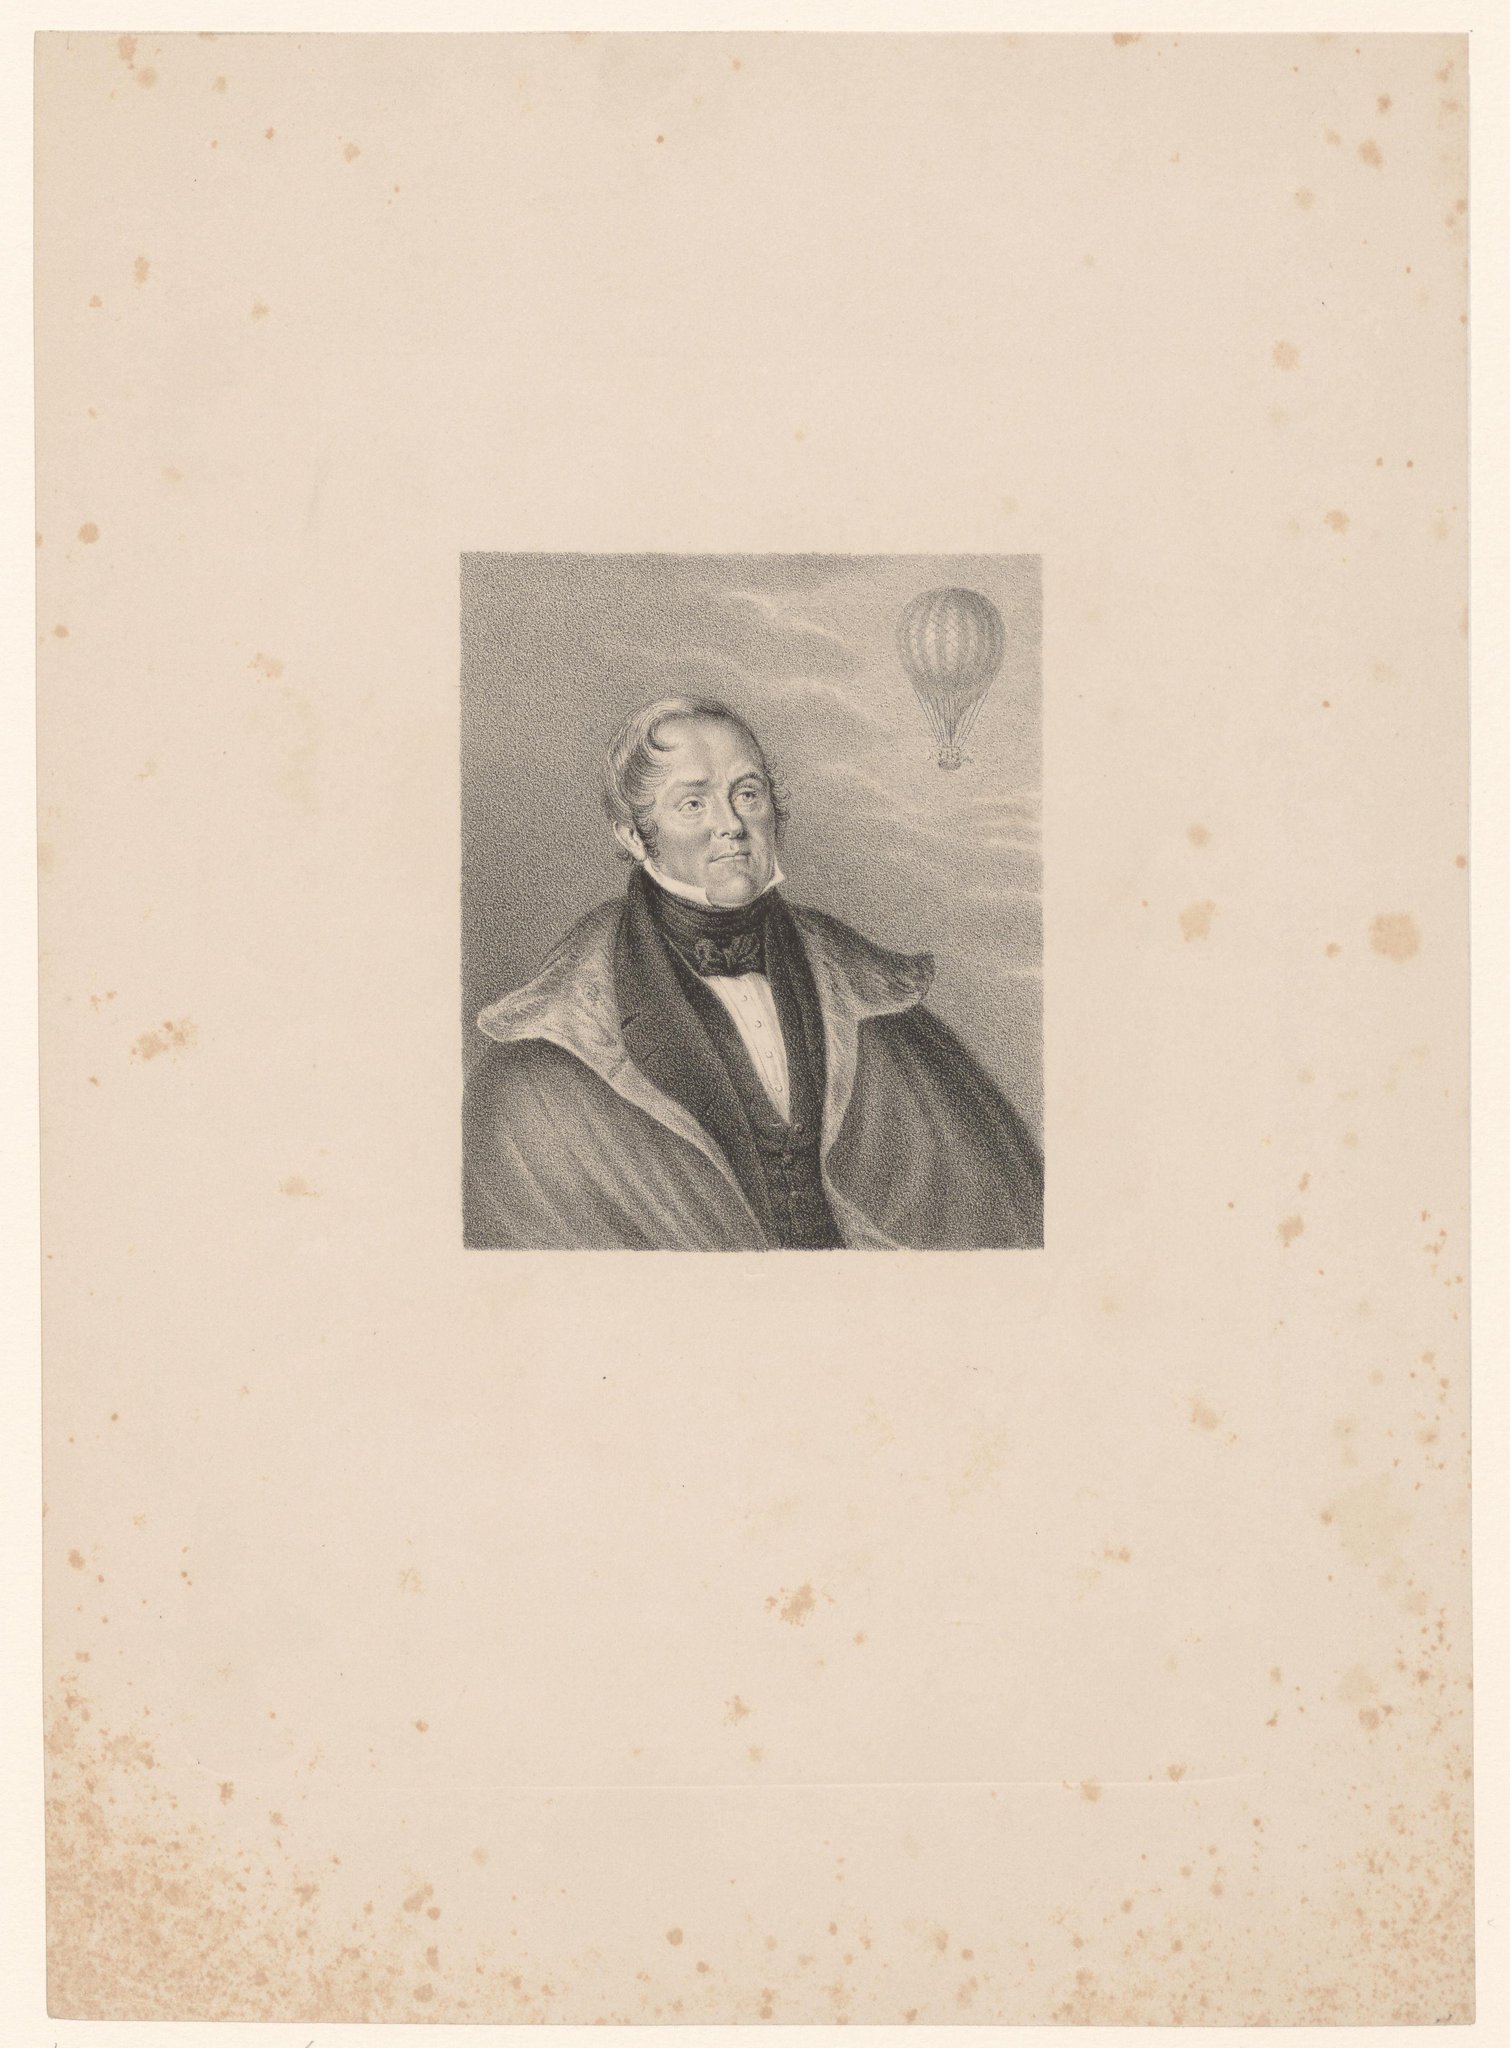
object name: print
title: Portret van Charles Green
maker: george perfect harding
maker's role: print maker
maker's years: 1780-1853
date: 1839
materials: paper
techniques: lithograph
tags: adult man, historical persons, balloon (aviation)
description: Charles Green was een bekende Engelse ballonvaarder.